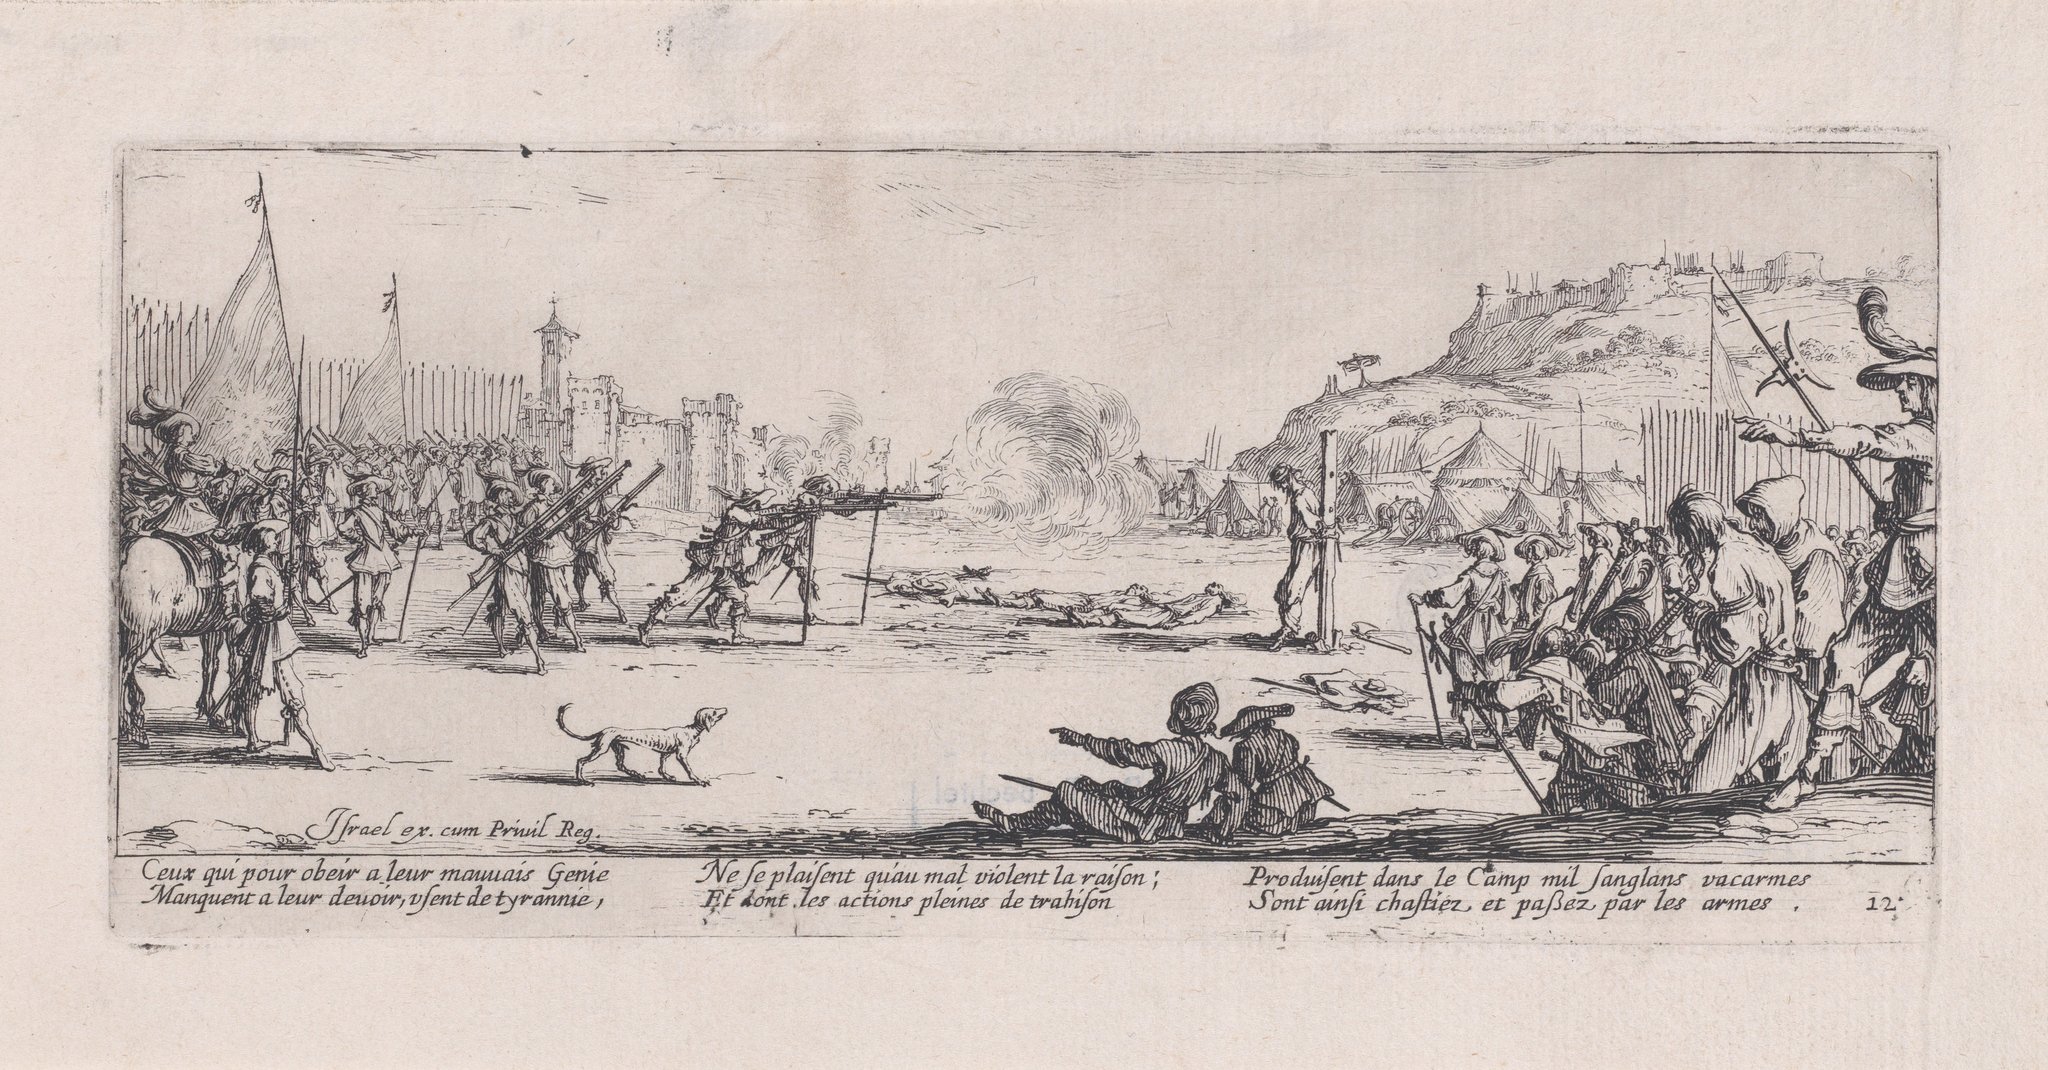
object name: print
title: L'Arquebusade (The Shot the Arquebus), plate 12 from "Les Misères et les Mal-Heures de la Guerre" (The Miseries and Misfortunes of War)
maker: jacques callot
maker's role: artist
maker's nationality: french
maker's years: 1592-1635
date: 1633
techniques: etching